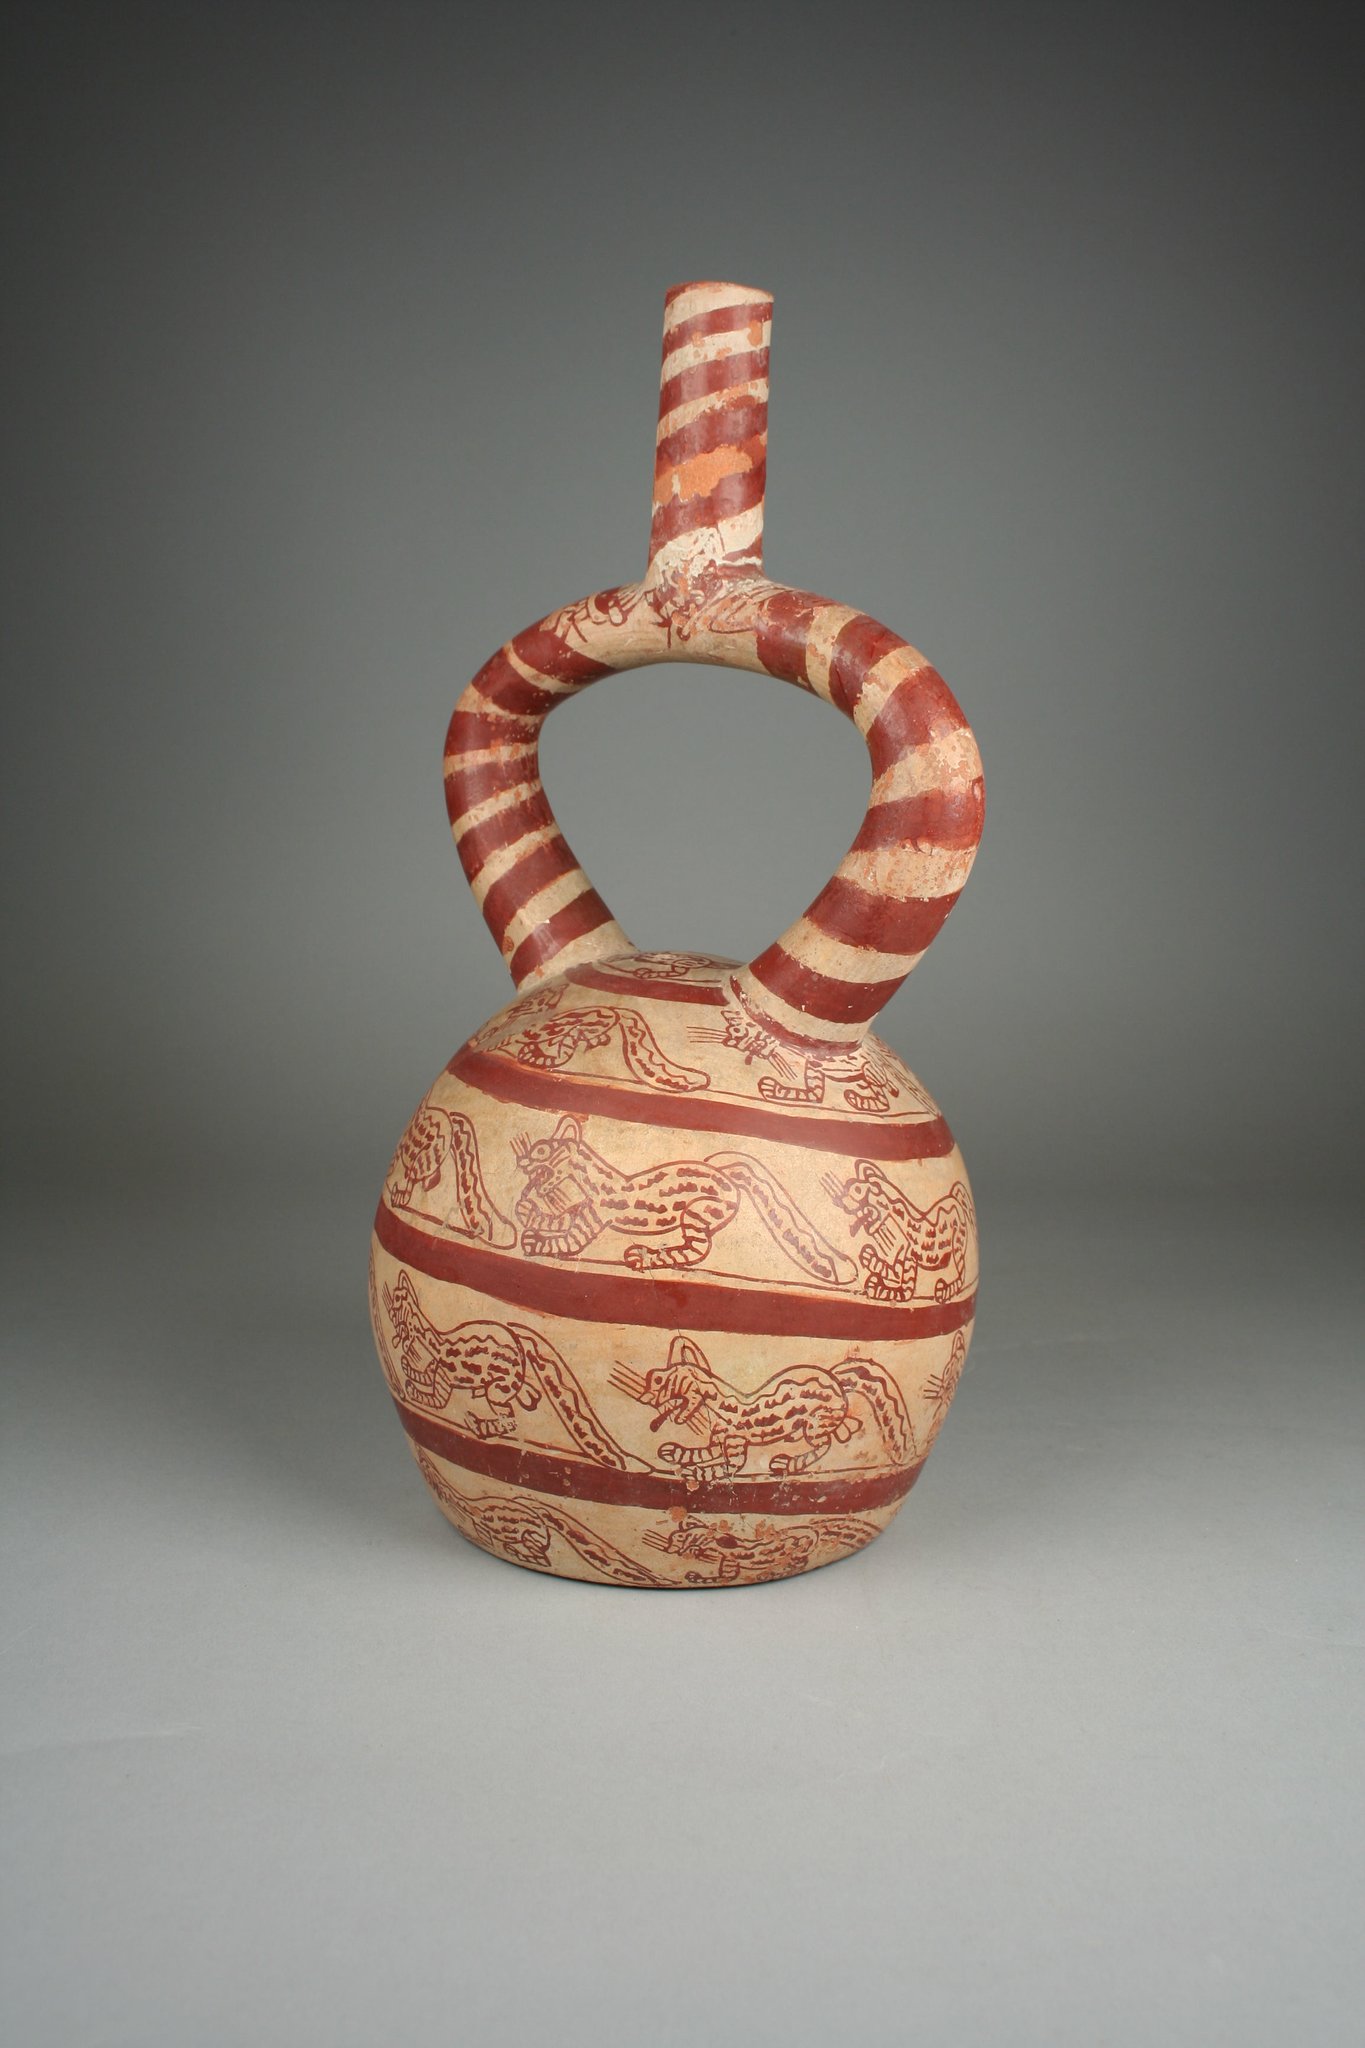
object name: bottle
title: Stirrup Spout Bottle with Felines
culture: moche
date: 301-700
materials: ceramic, pigment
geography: peru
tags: animals